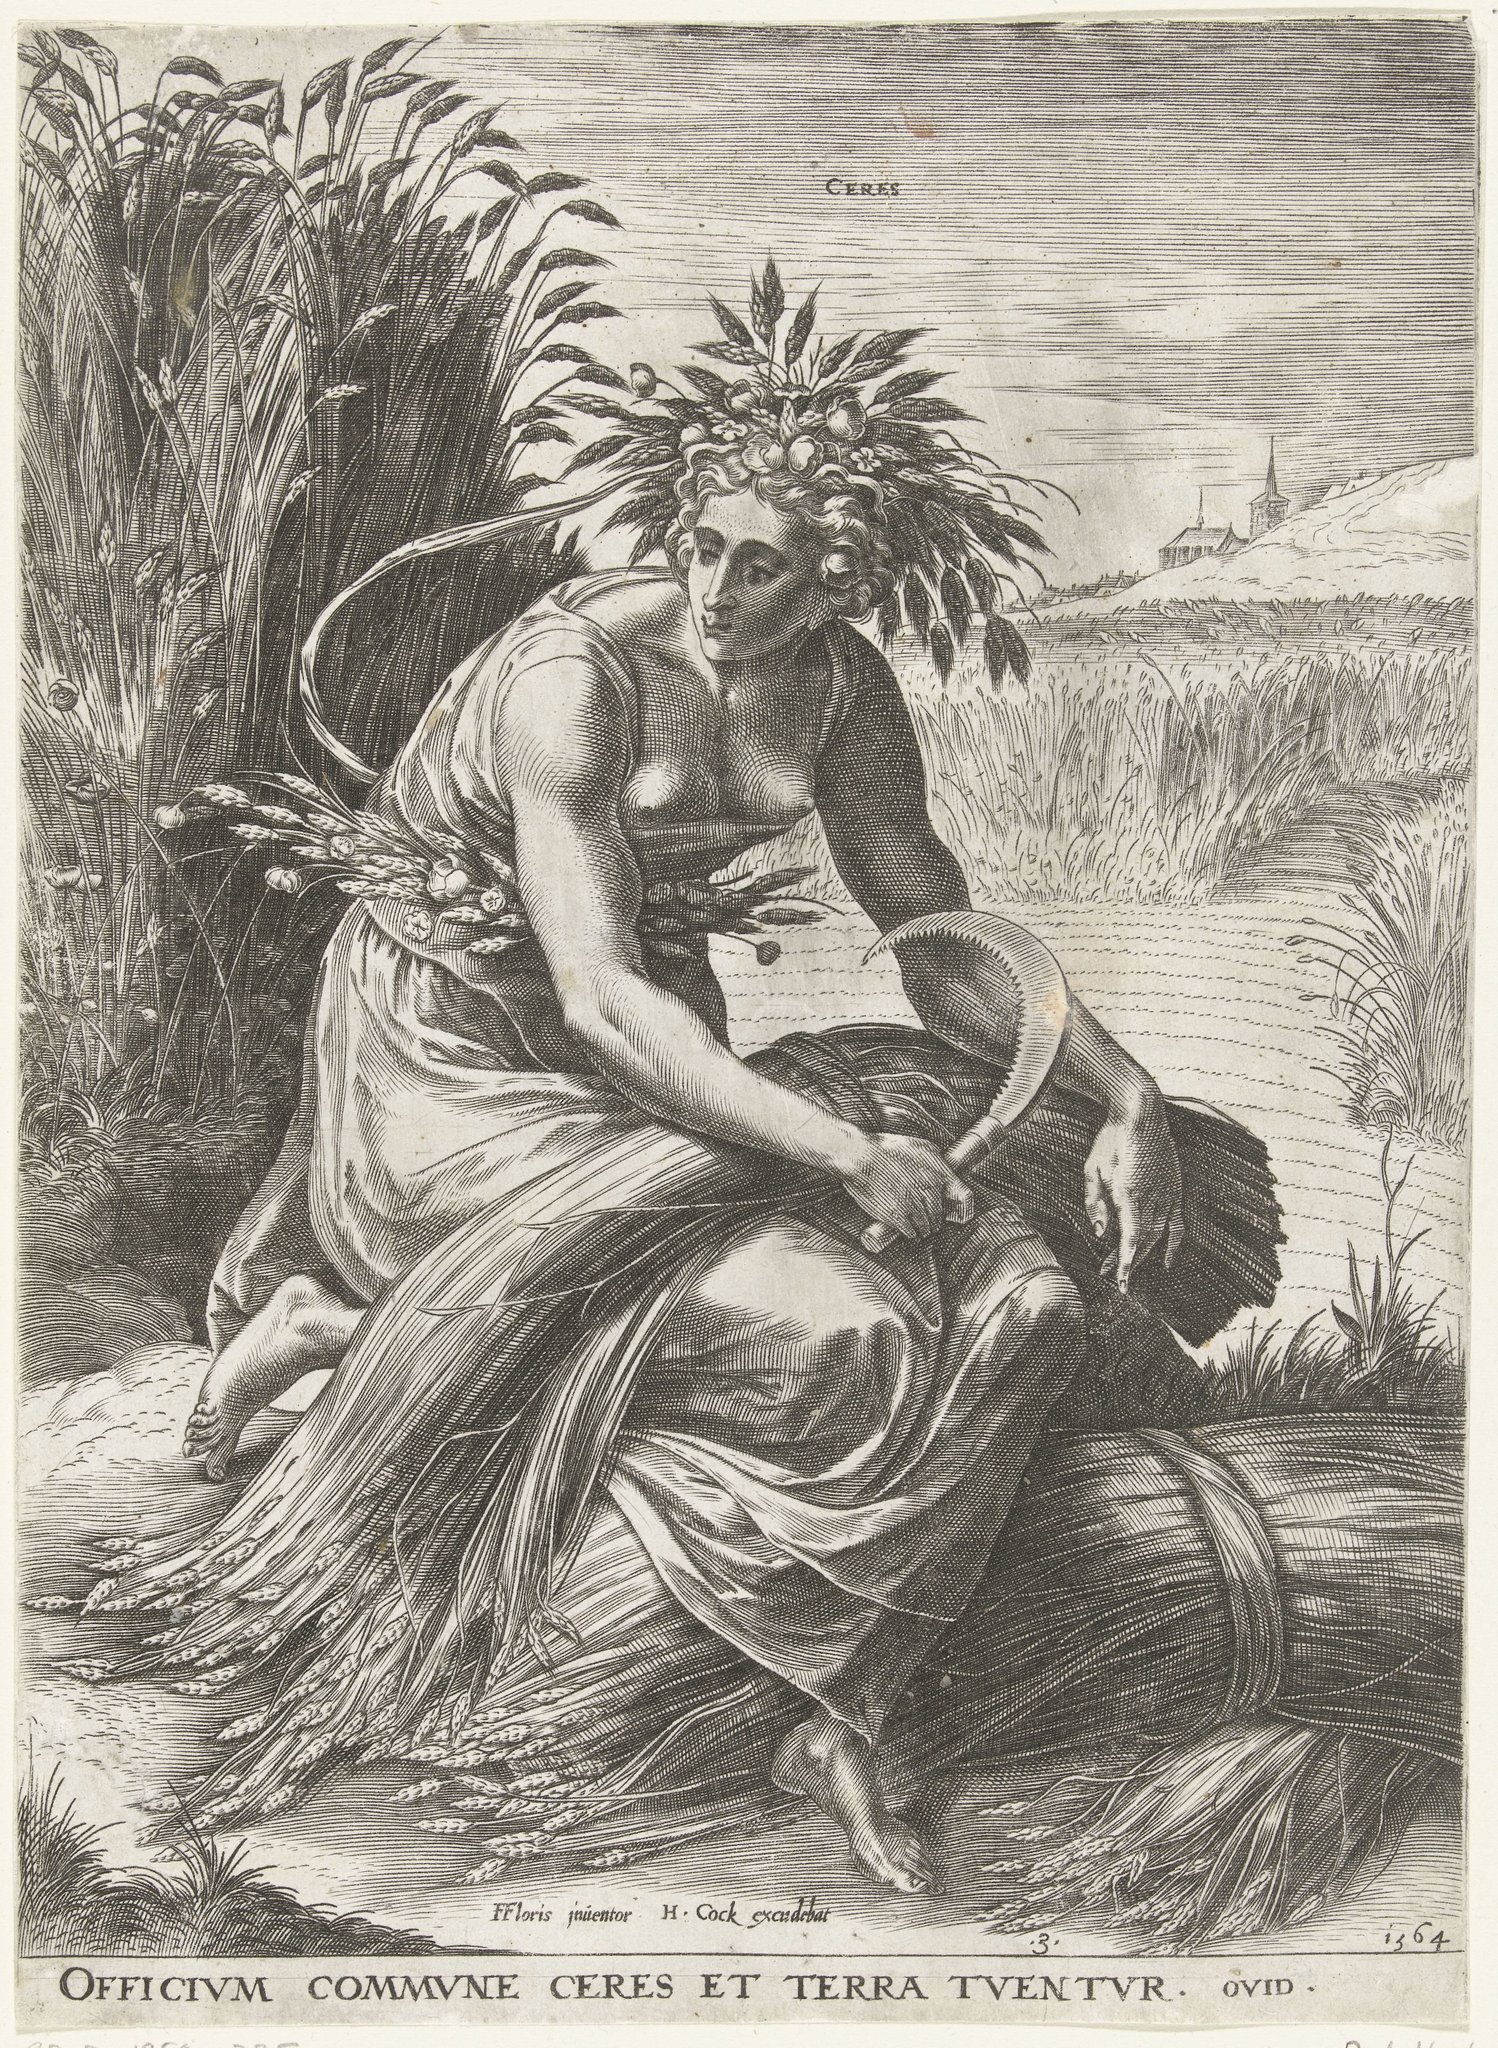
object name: print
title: Ceres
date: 1564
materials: paper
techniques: engraving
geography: antwerp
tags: (story of) ceres (demeter)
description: Ceres de godin van de akkerbouw bij de graanoogst. Ceres knielt bij een hoop met korenaren met een sikkel in de hand.